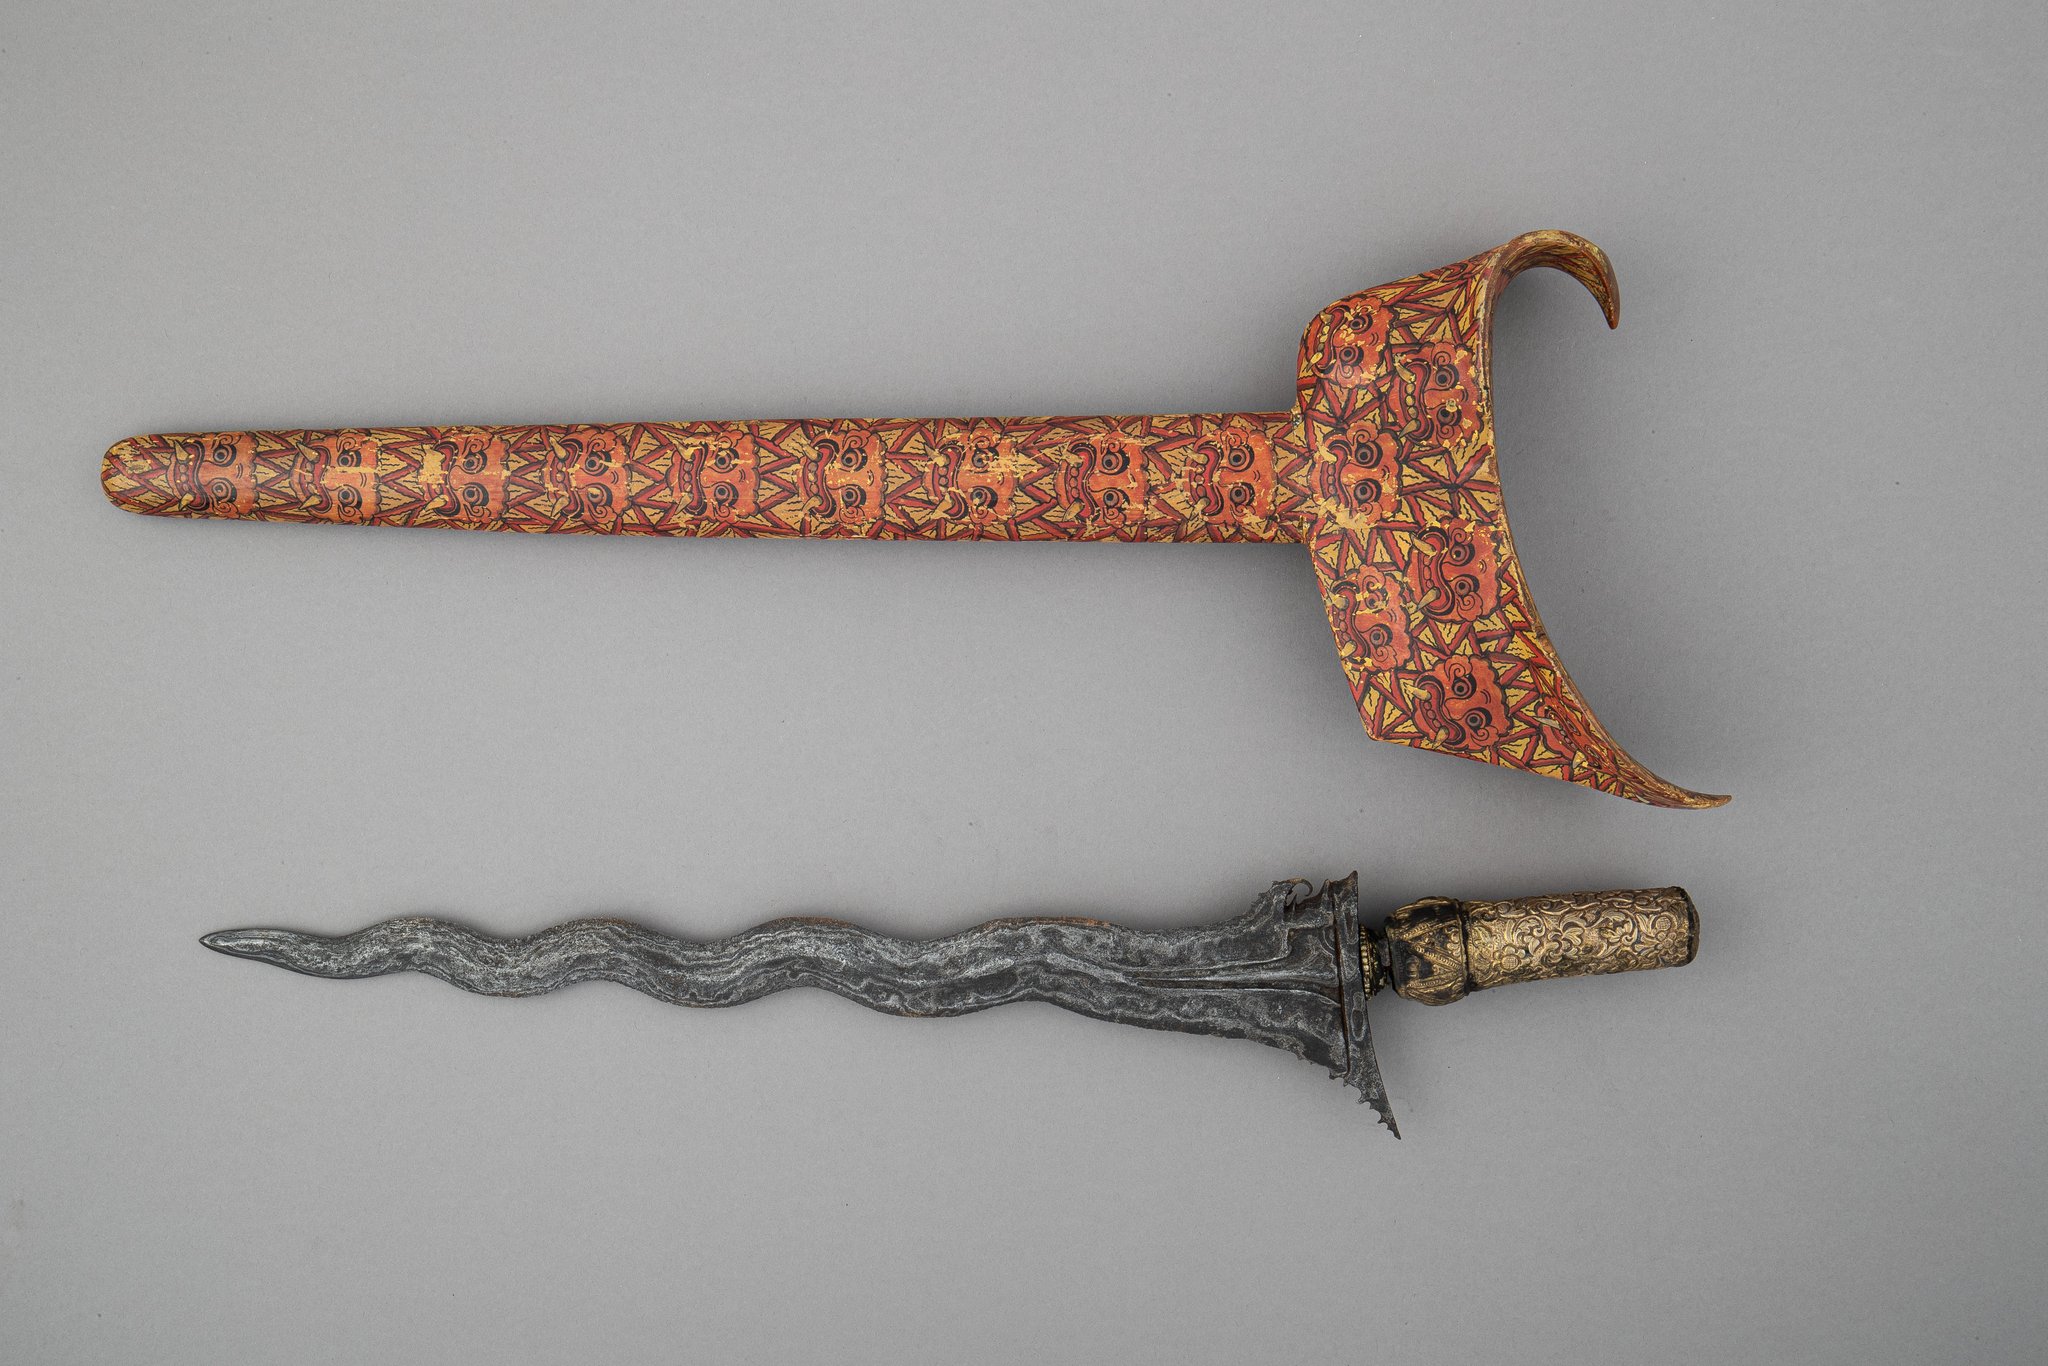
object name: kris with sheath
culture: madurese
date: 1501-1900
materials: brass, steel, wood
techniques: polychromy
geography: indonesia